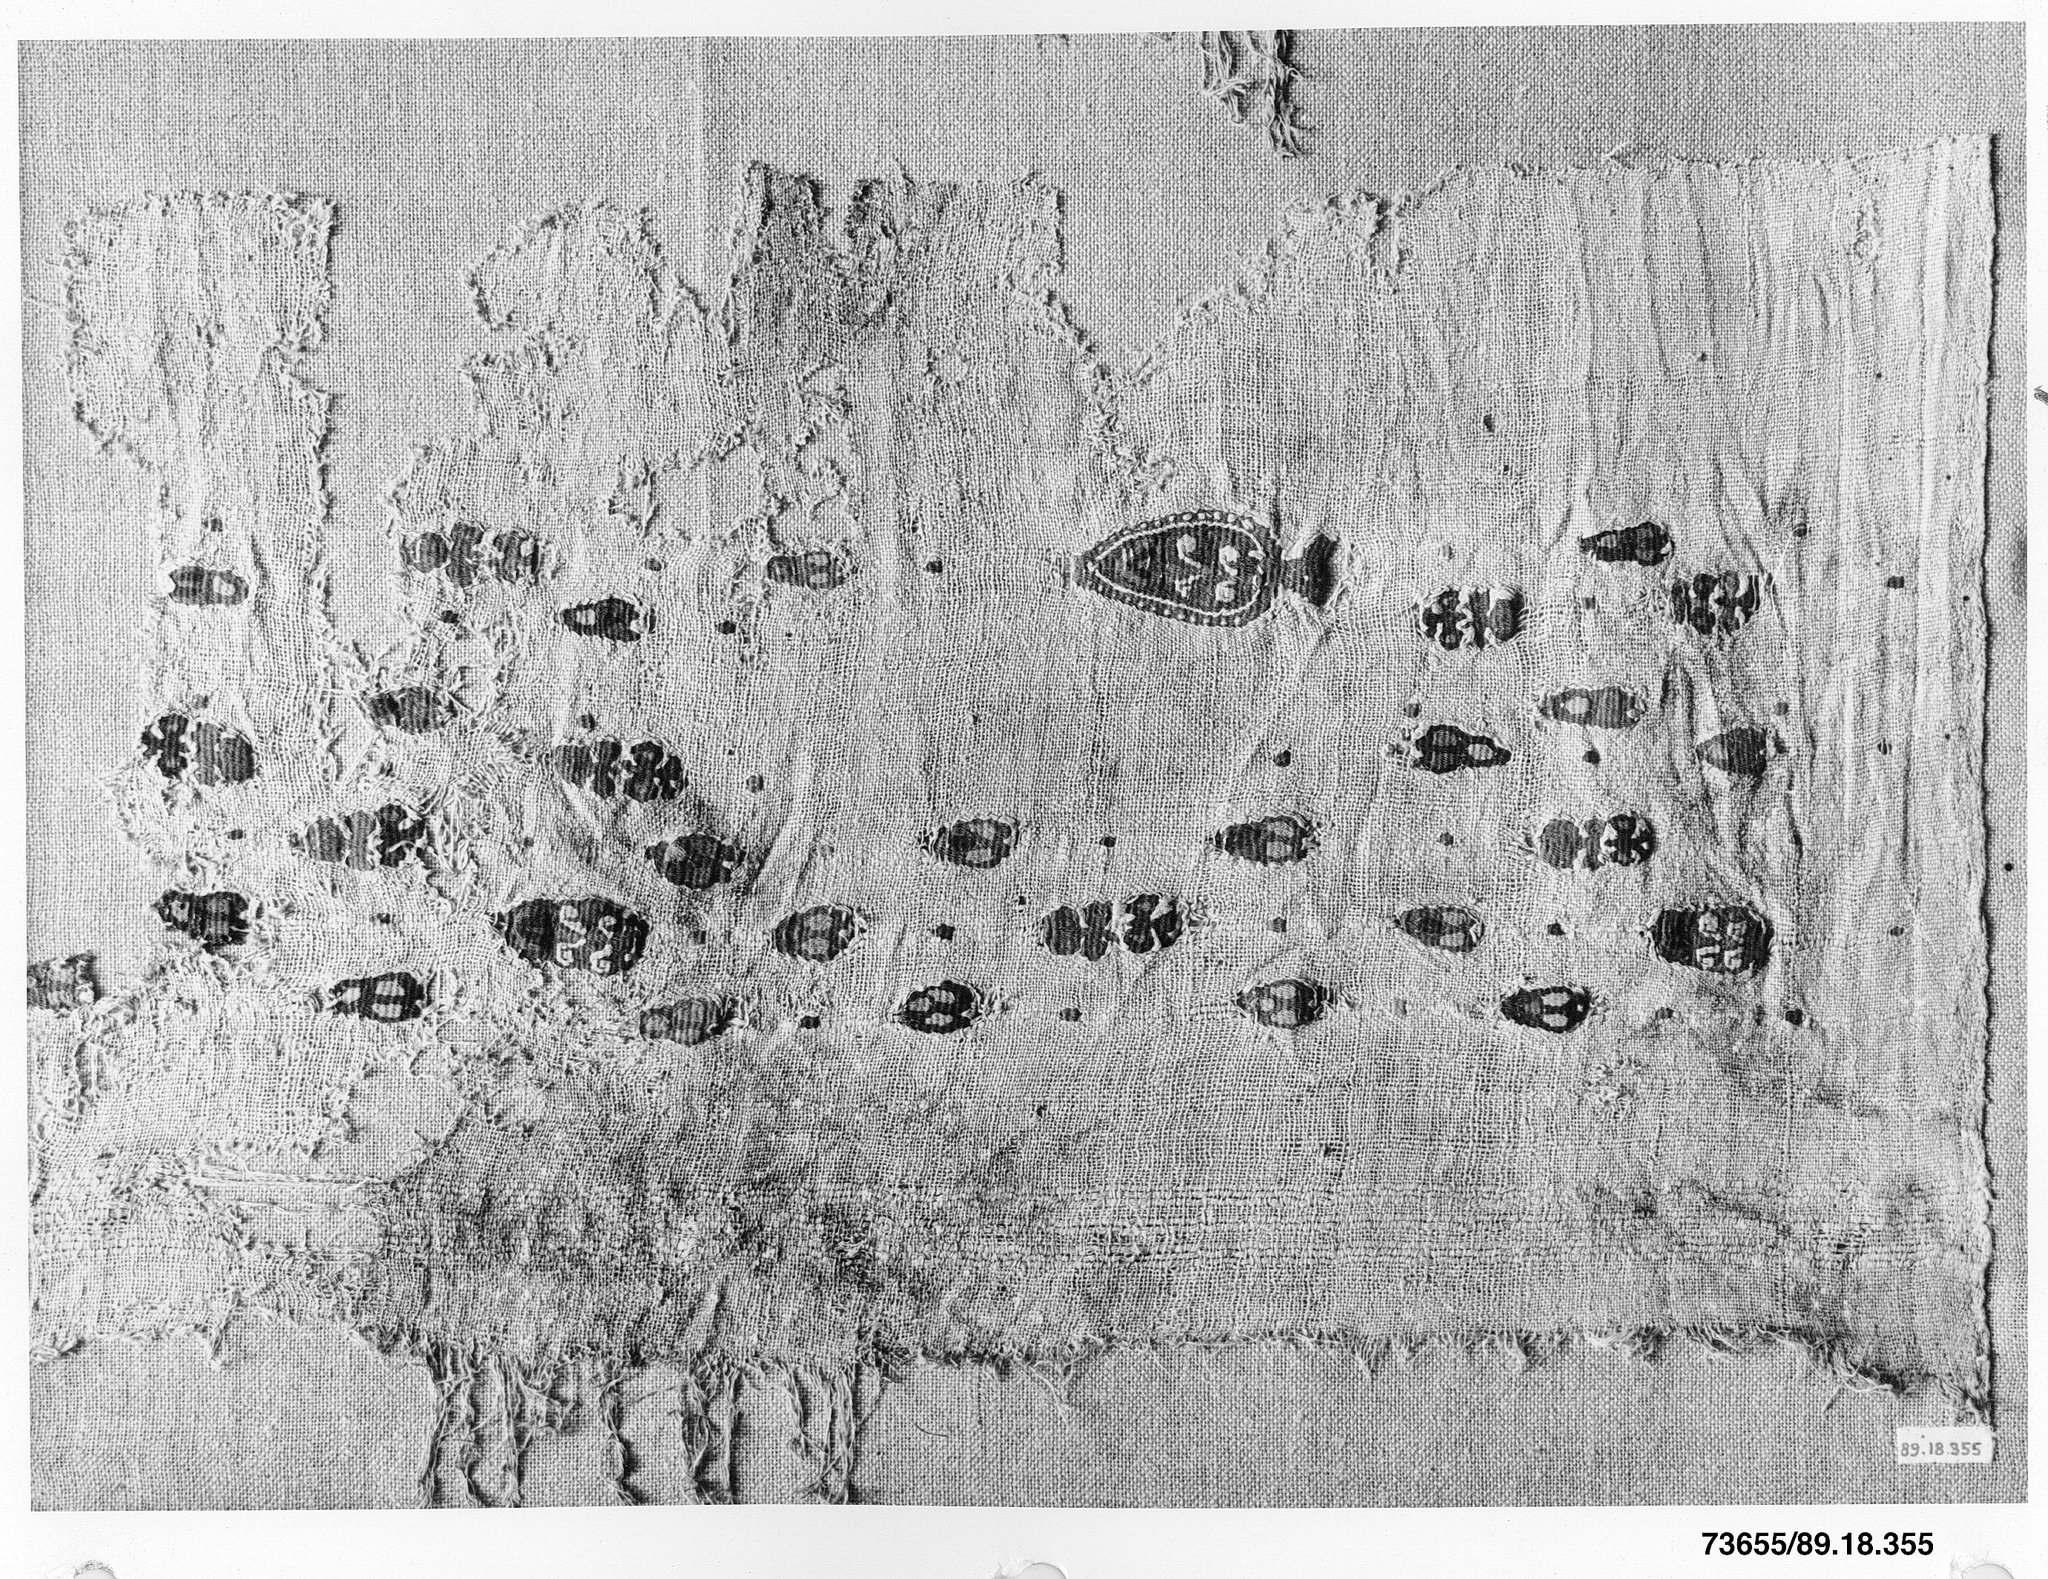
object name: textile fragment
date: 401-600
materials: linen, wool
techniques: weave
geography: egypt